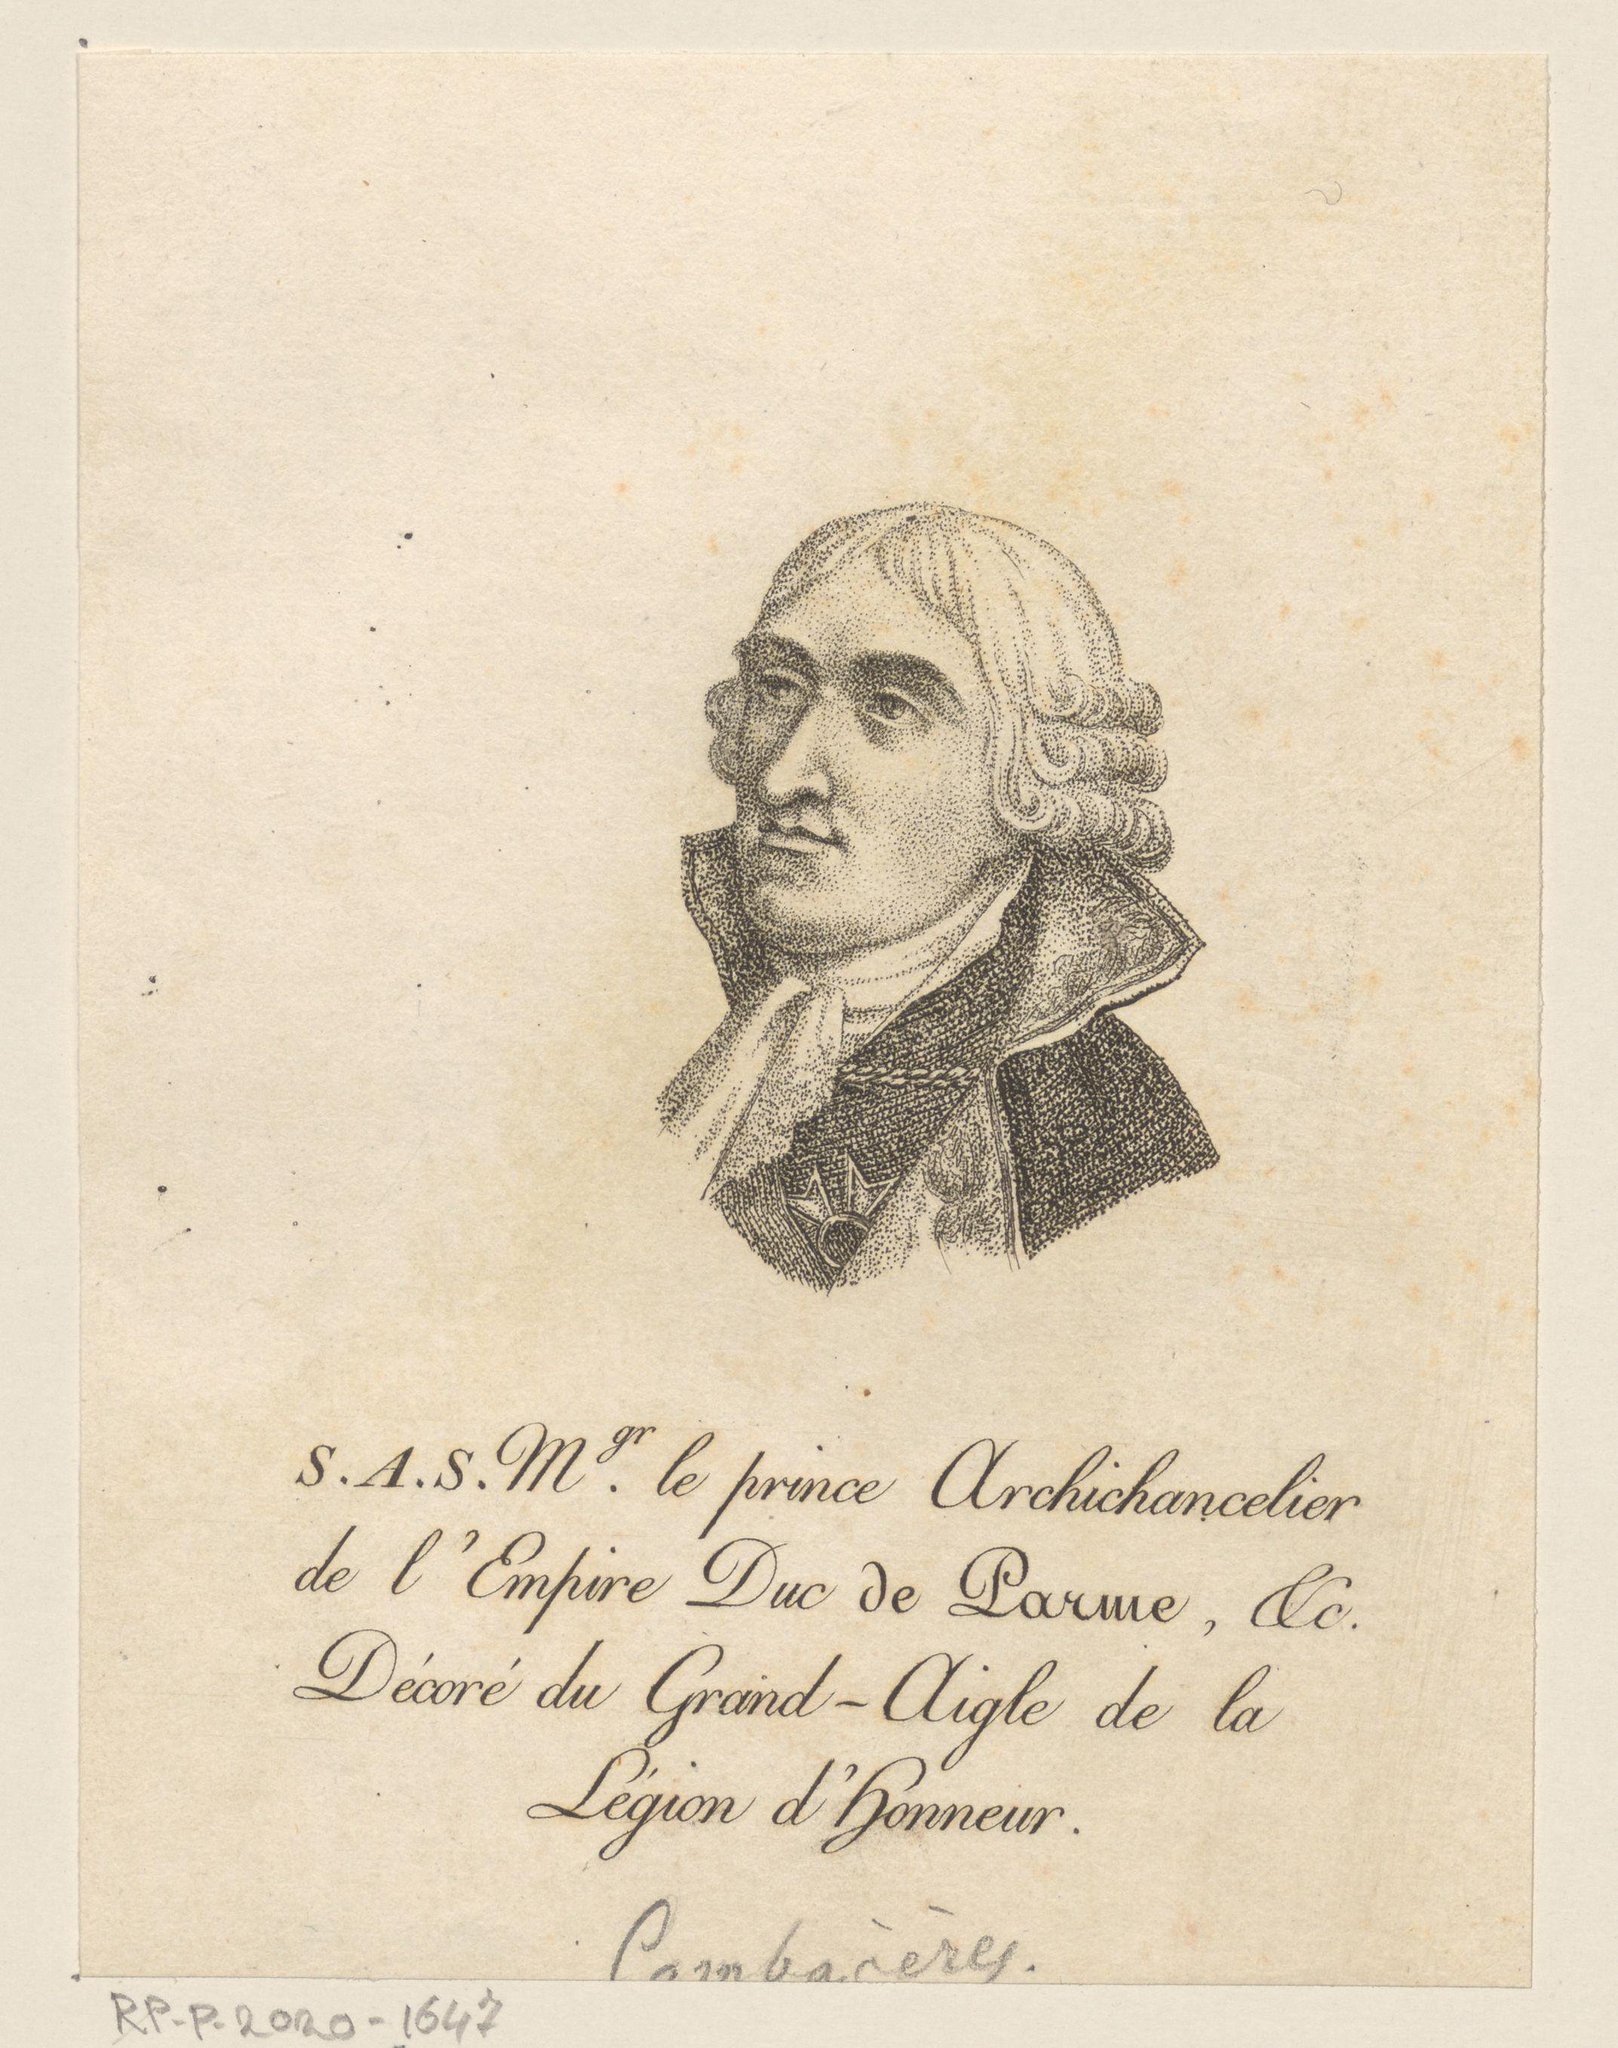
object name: print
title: Portret van Jean-Jacques Régis de Cambacérès, hertog van Parma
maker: Anonymous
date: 1810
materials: paper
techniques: engraving, etching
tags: paris, politician, historical persons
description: Prent mogelijk uit: Meyer, M. Collection complète des portraits des Grands-Aigles et des Grands-Officiers de la Légion d'Honneur (...). Parijs: M. Meyer, 1810.